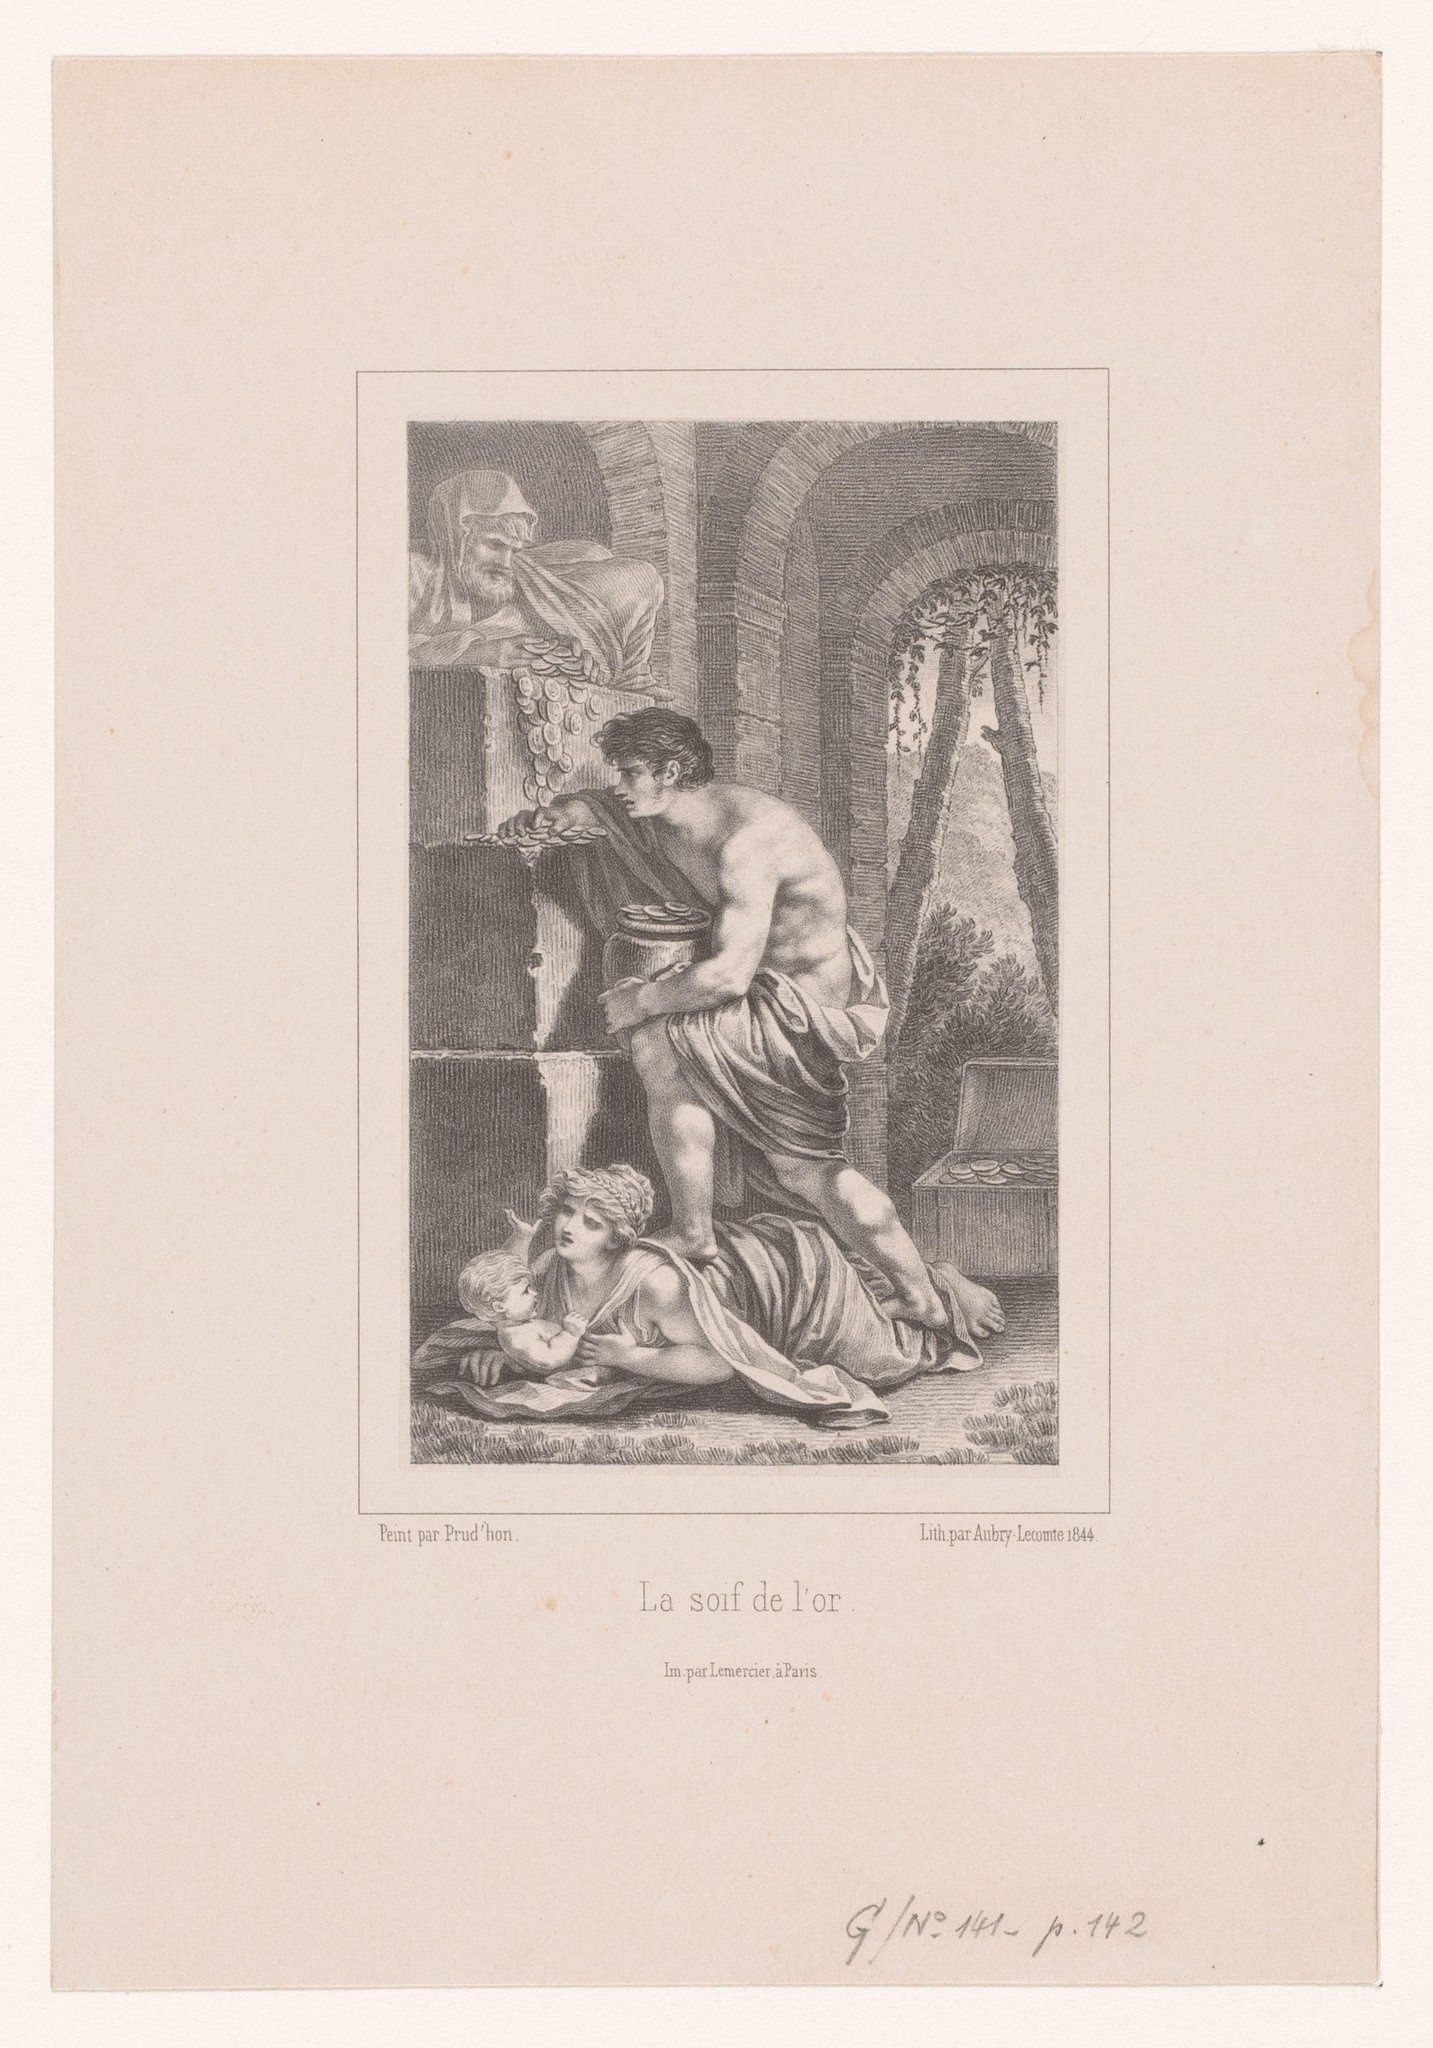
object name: print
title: Edouard en het goud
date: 1844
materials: paper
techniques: lithograph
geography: paris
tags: treasure hunting, goldrush, literary characters and objects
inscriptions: collector's mark: Lugt 2228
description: Scène uit "La Tribu Indienne" van Lucien Bonaparte.